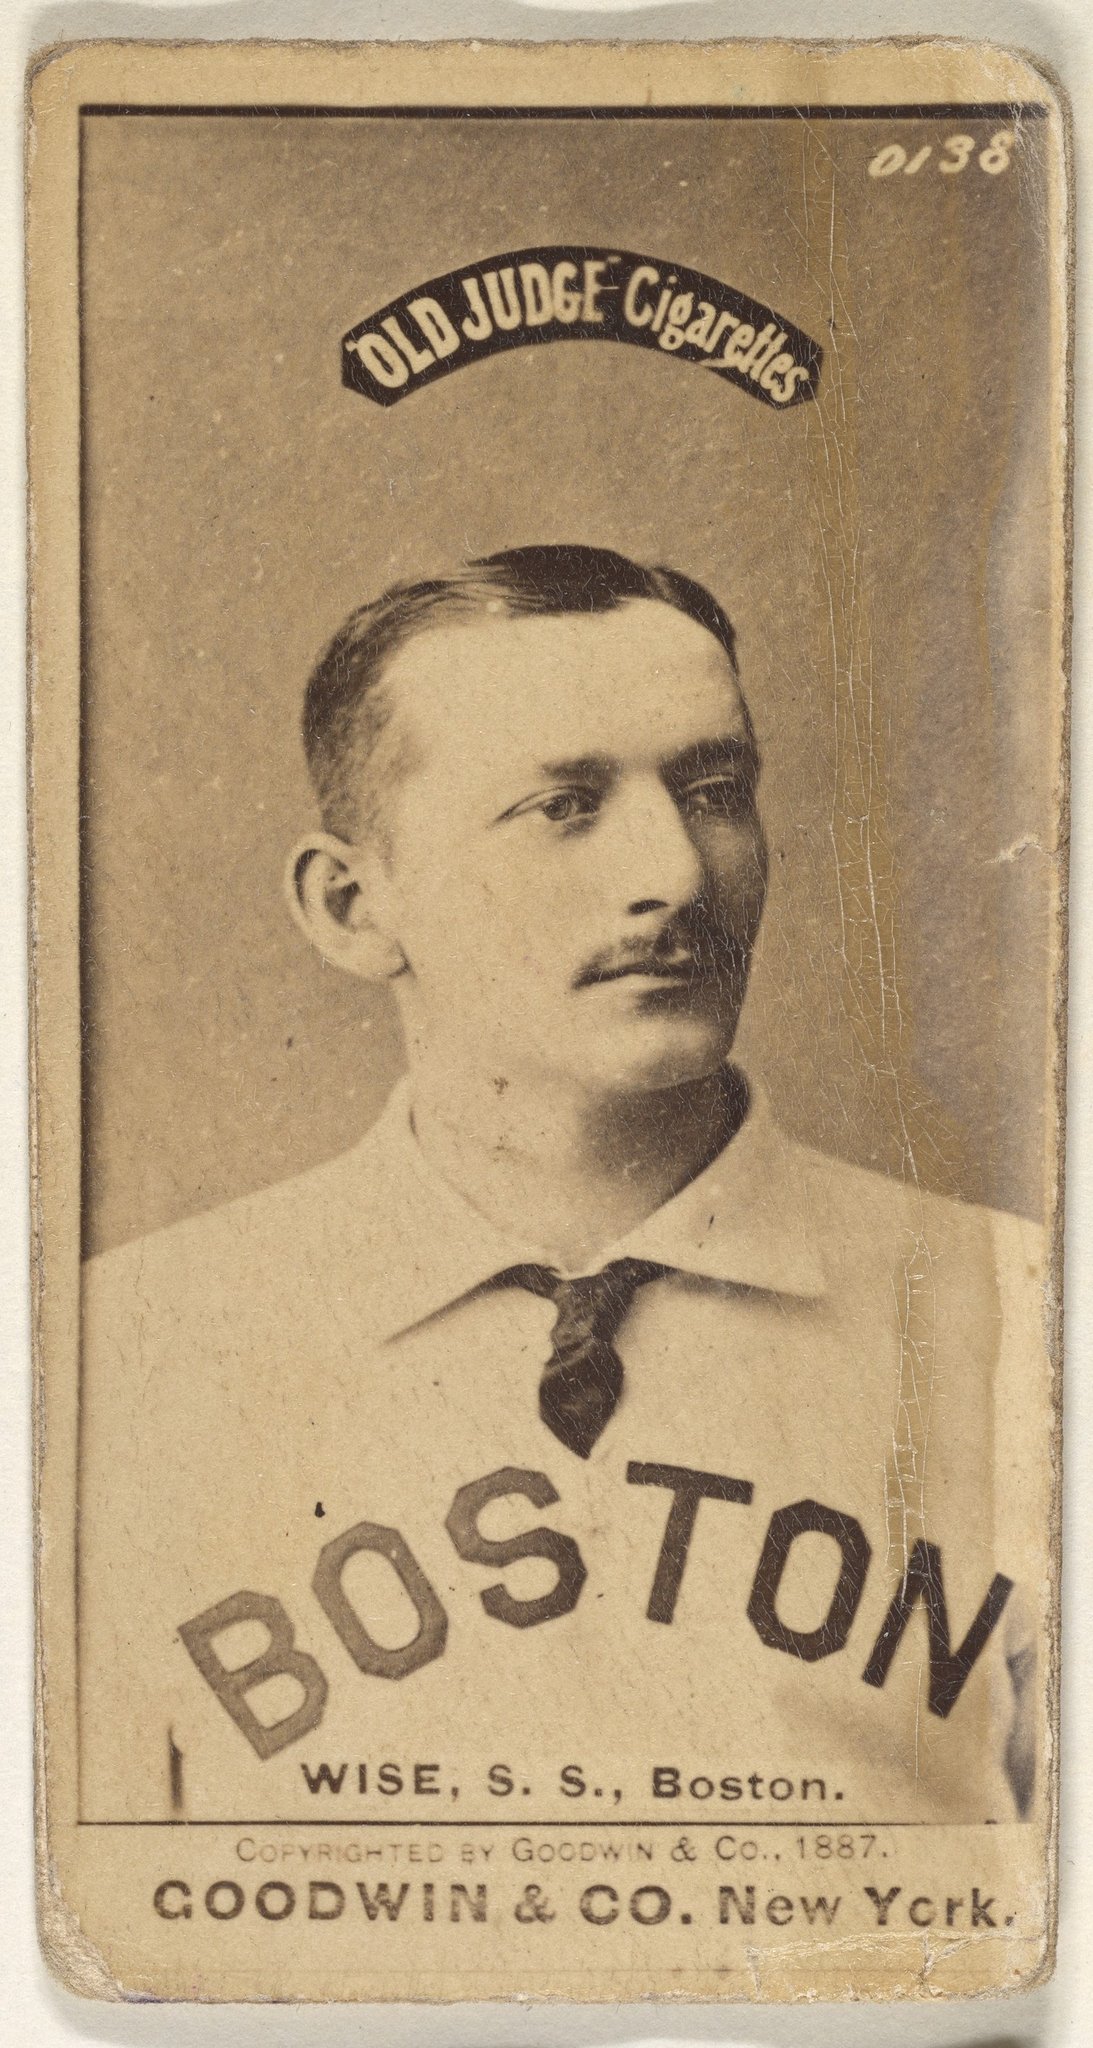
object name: baseball card, photograph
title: Wise, Shortstop, Boston, from the Old Judge series (N172) for Old Judge Cigarettes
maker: goodwin & company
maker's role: publisher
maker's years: 1850-1950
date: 1887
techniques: albumen silver print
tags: men,portraits,baseball,athletes